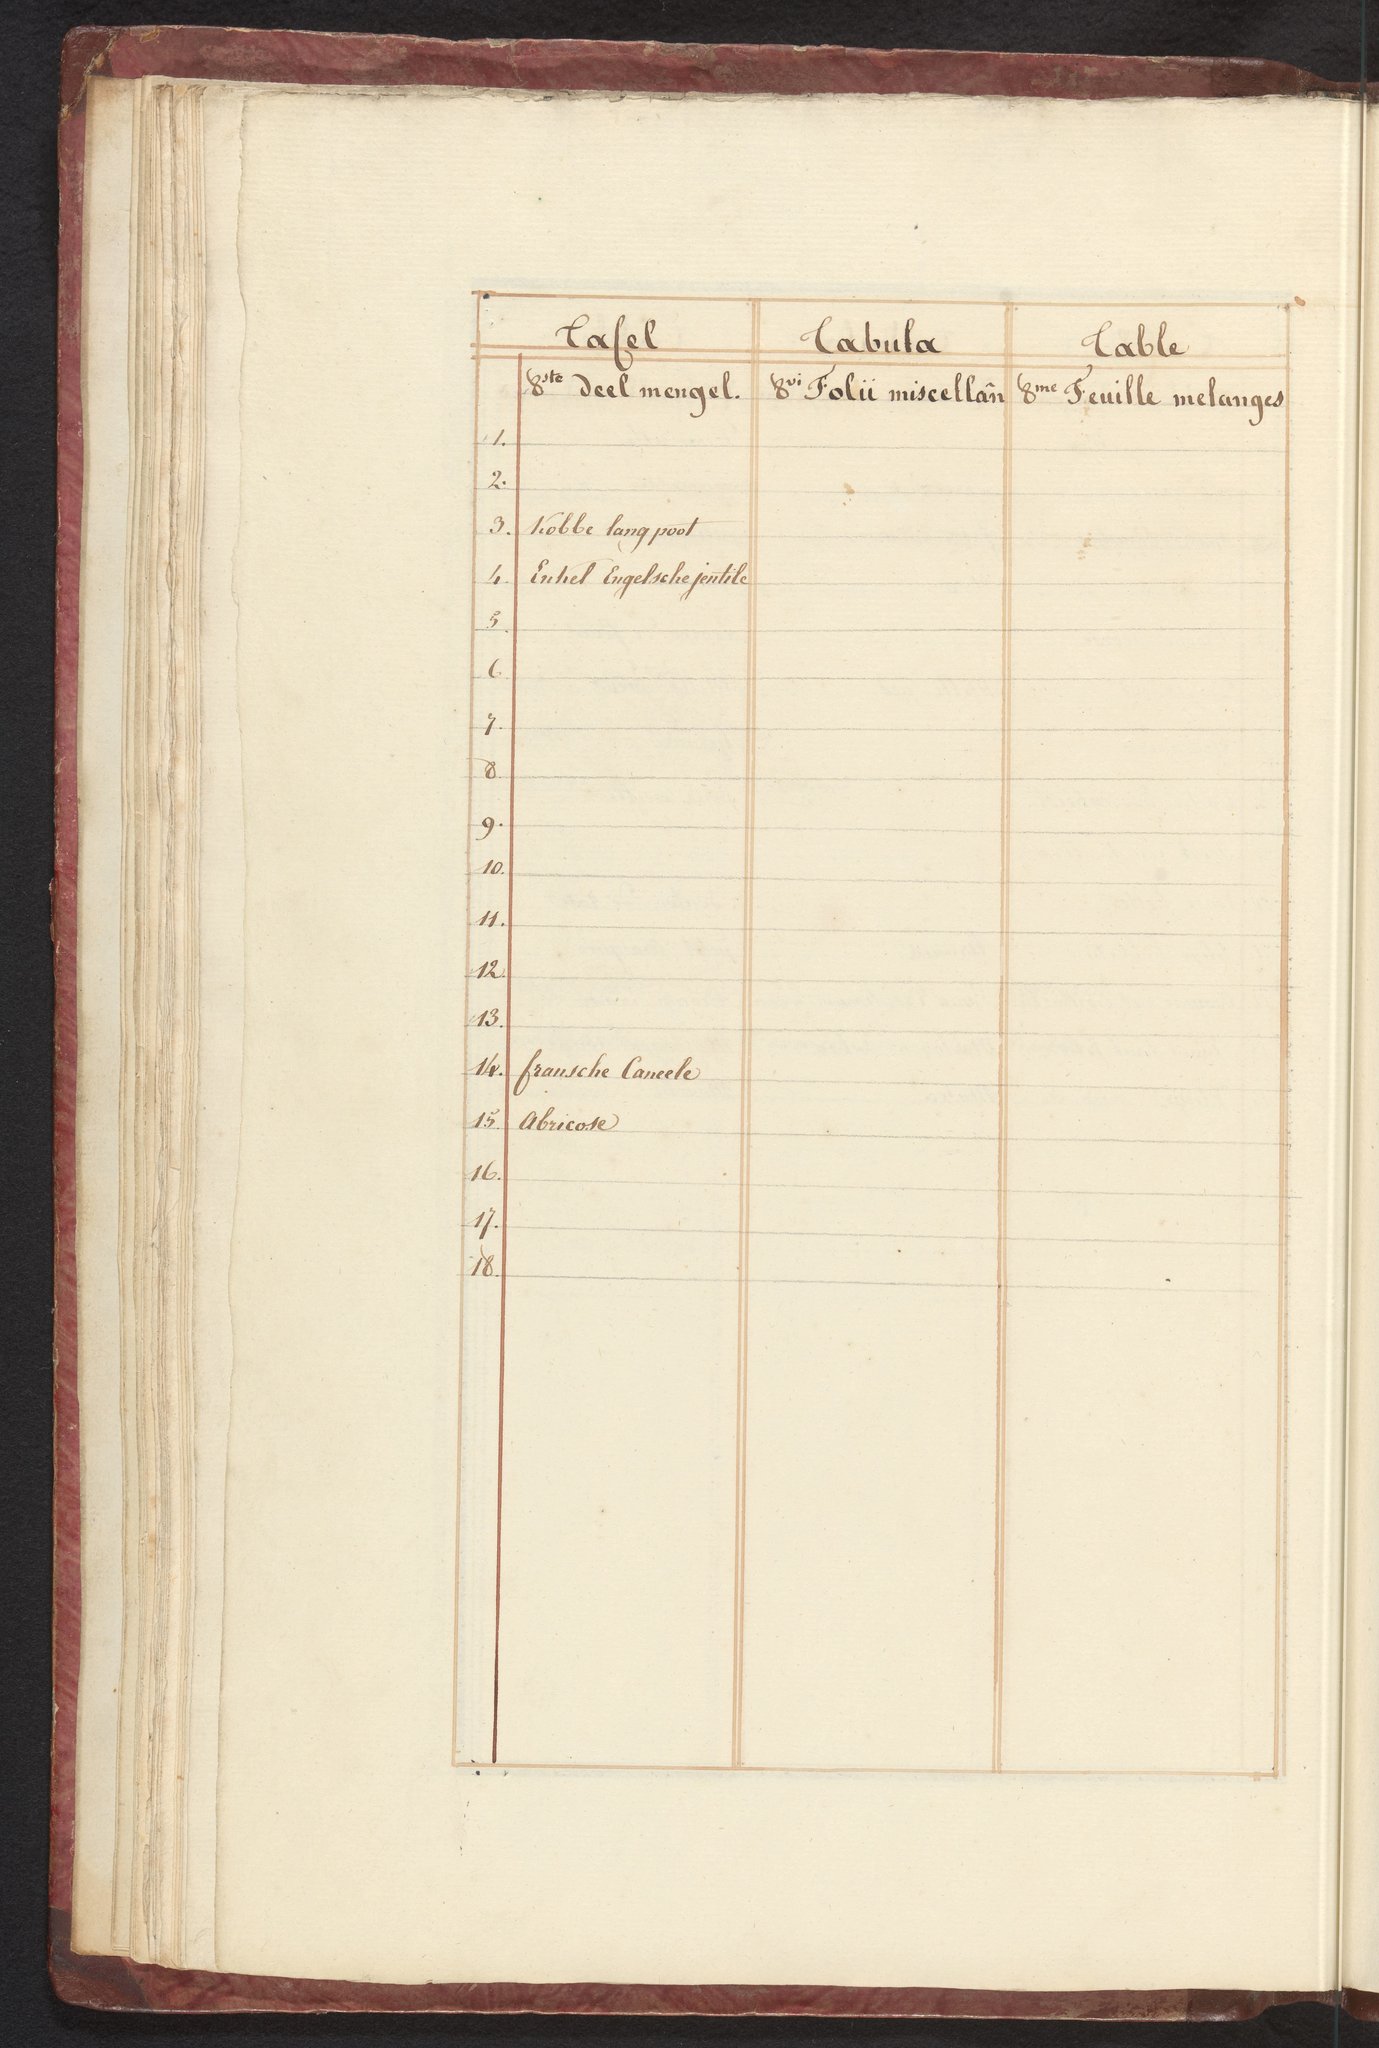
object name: manuscript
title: Tafel 8ste blad mengel. / Tabula 8vi Folii miscellan. / Table 8me Feuille melanges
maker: joseph van huerne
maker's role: kunstliefhebber, mecenas, verzamelaar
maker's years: 1752-1844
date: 1809-1814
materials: ink, paper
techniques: handwriting, pen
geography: bruges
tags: handwriting, written text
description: Schema met een lijst in drie kolommen van de dieren en planten afgebeeld in het achtste ensemble, nummers 1-18. Onderdeel van het zevende album met tekeningen van reptielen, amfibieën en natuurhistorische ensembles. Het zevende van twaalf albums met aquarellen van dieren, vogels en planten bekend rond 1600, gemaakt in opdracht van keizer Rudolf II. Met toelichting in Nederlands, Latijn en Frans.